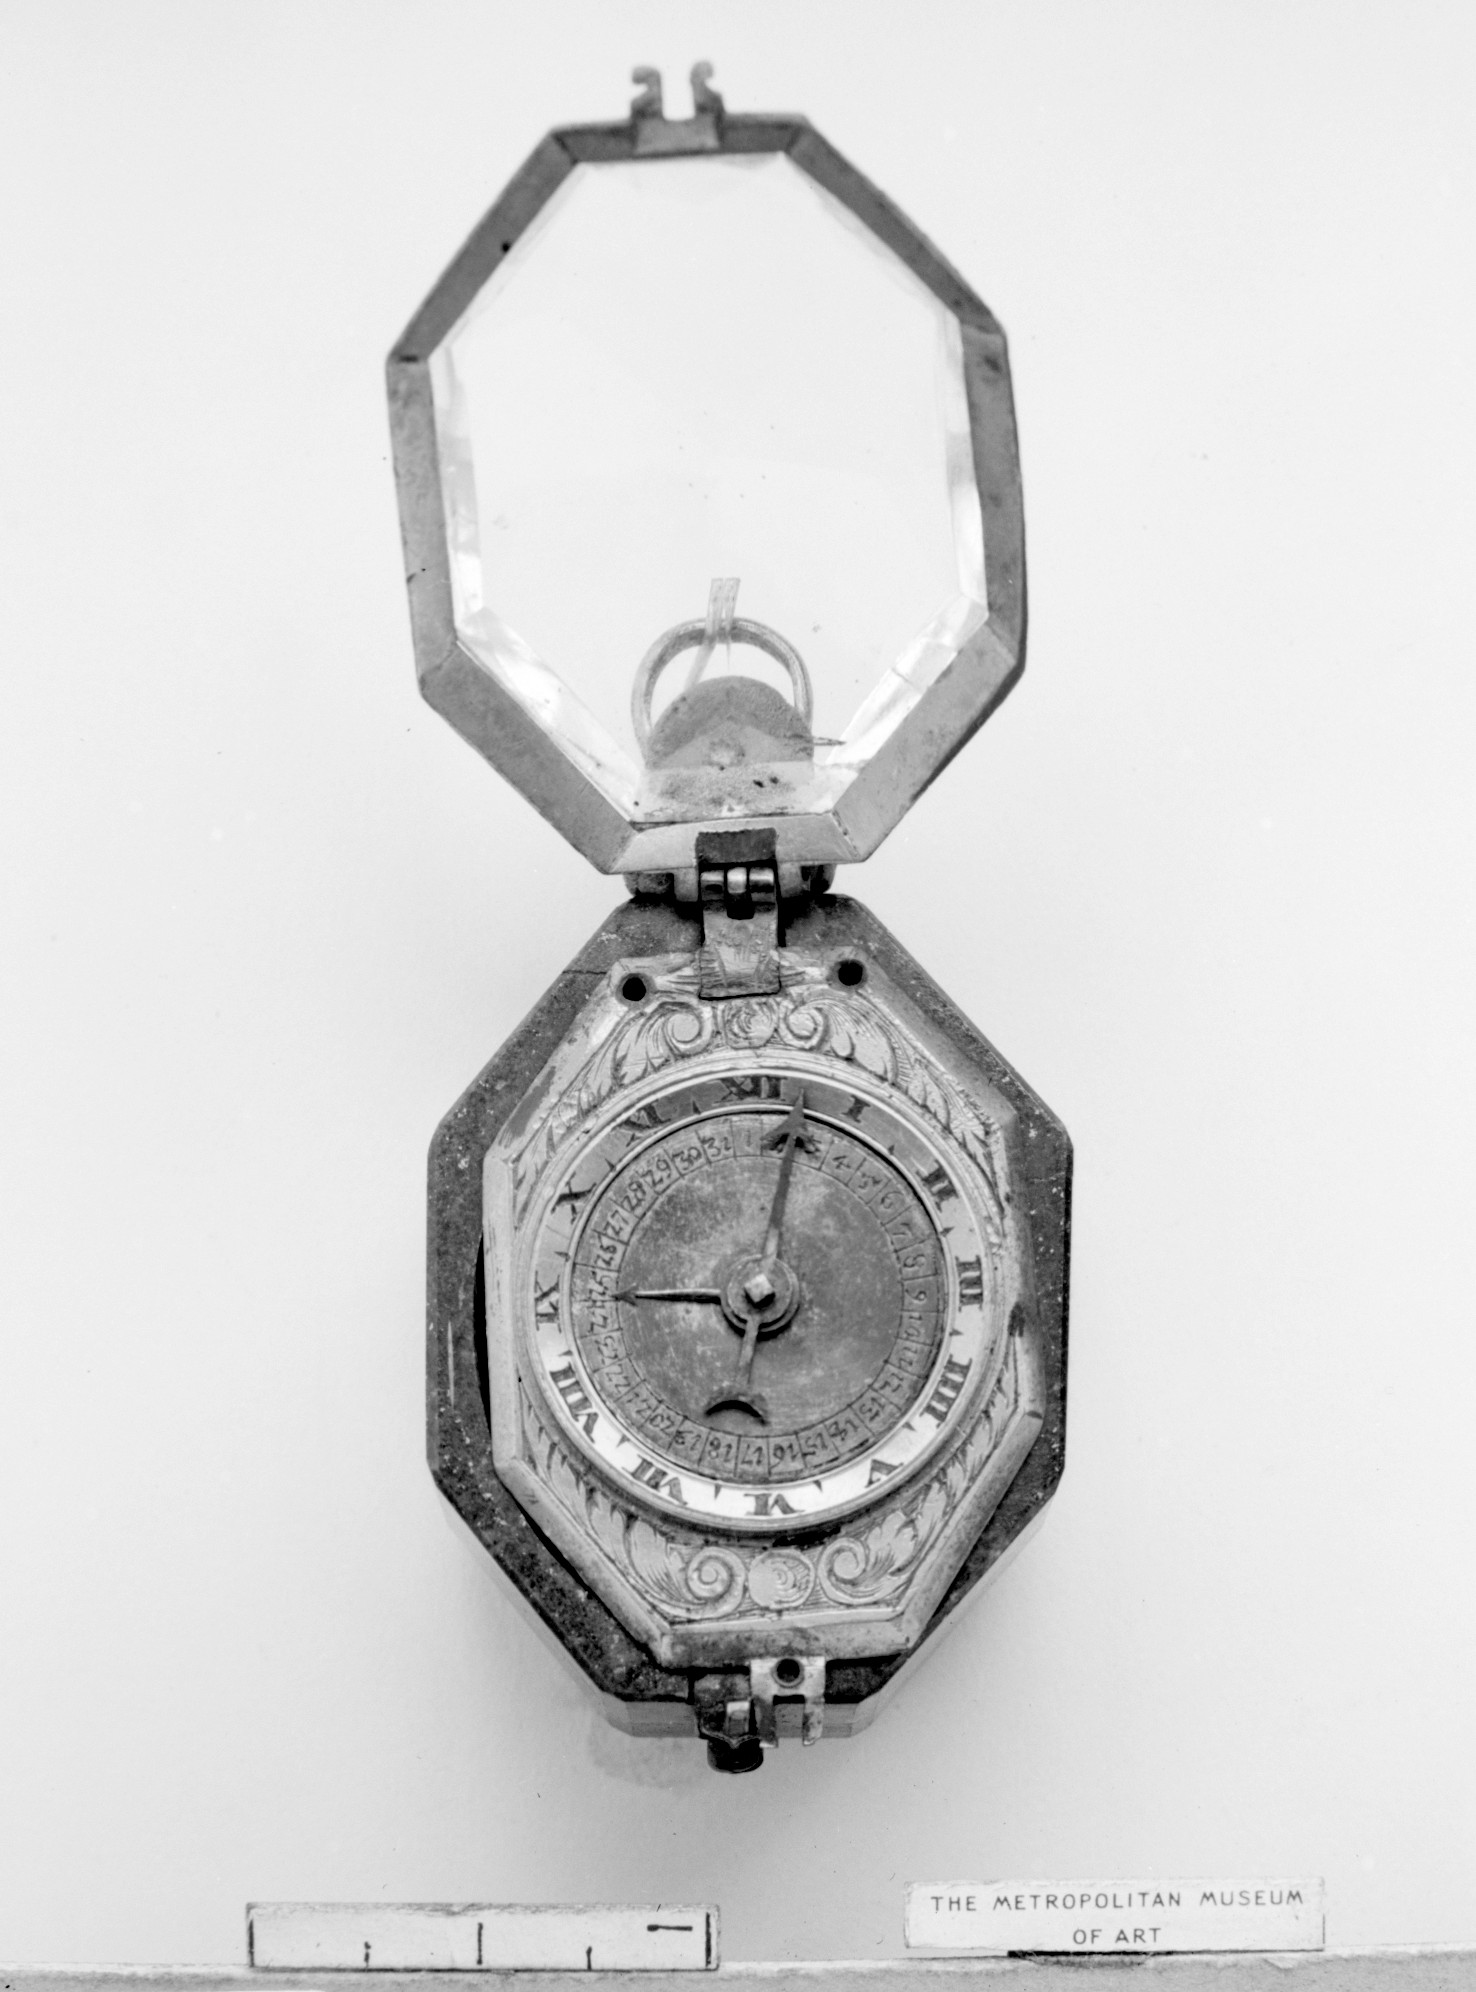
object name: watch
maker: nicolaus rugendas the elder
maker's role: maker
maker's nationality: german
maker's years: 1585-1658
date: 1620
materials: gilt, lapis lazuli, metal, quartz